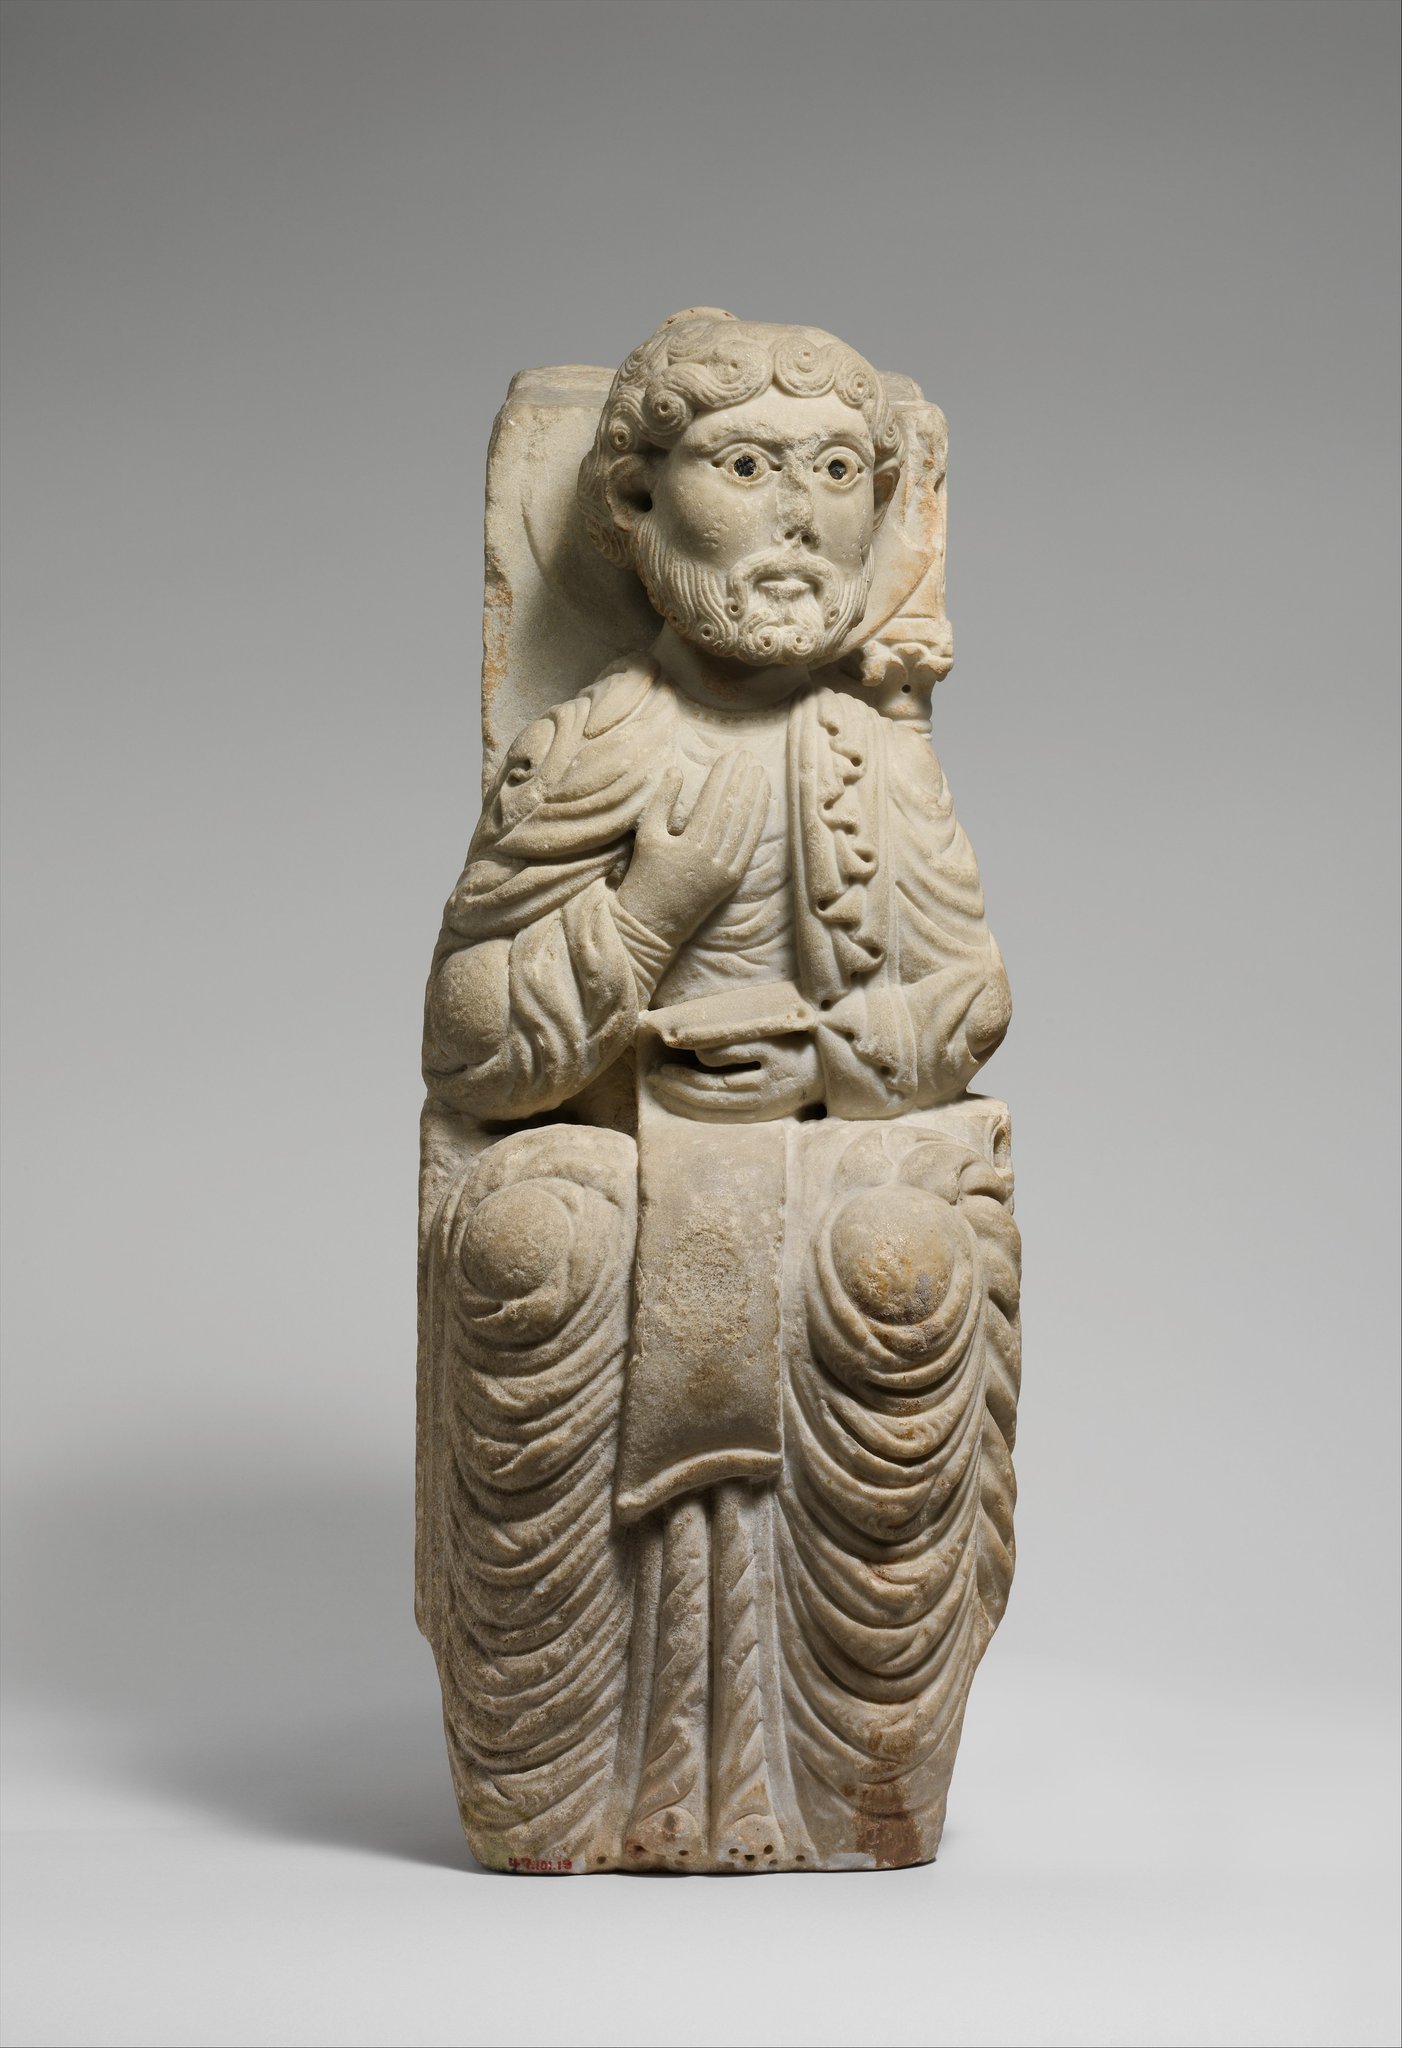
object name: sculpture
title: Seated Figure (Prophet or Apostle)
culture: italian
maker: master of santa maria la bianca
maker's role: artist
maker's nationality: italian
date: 1200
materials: lead, marble, stone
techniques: inlay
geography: central italy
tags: men